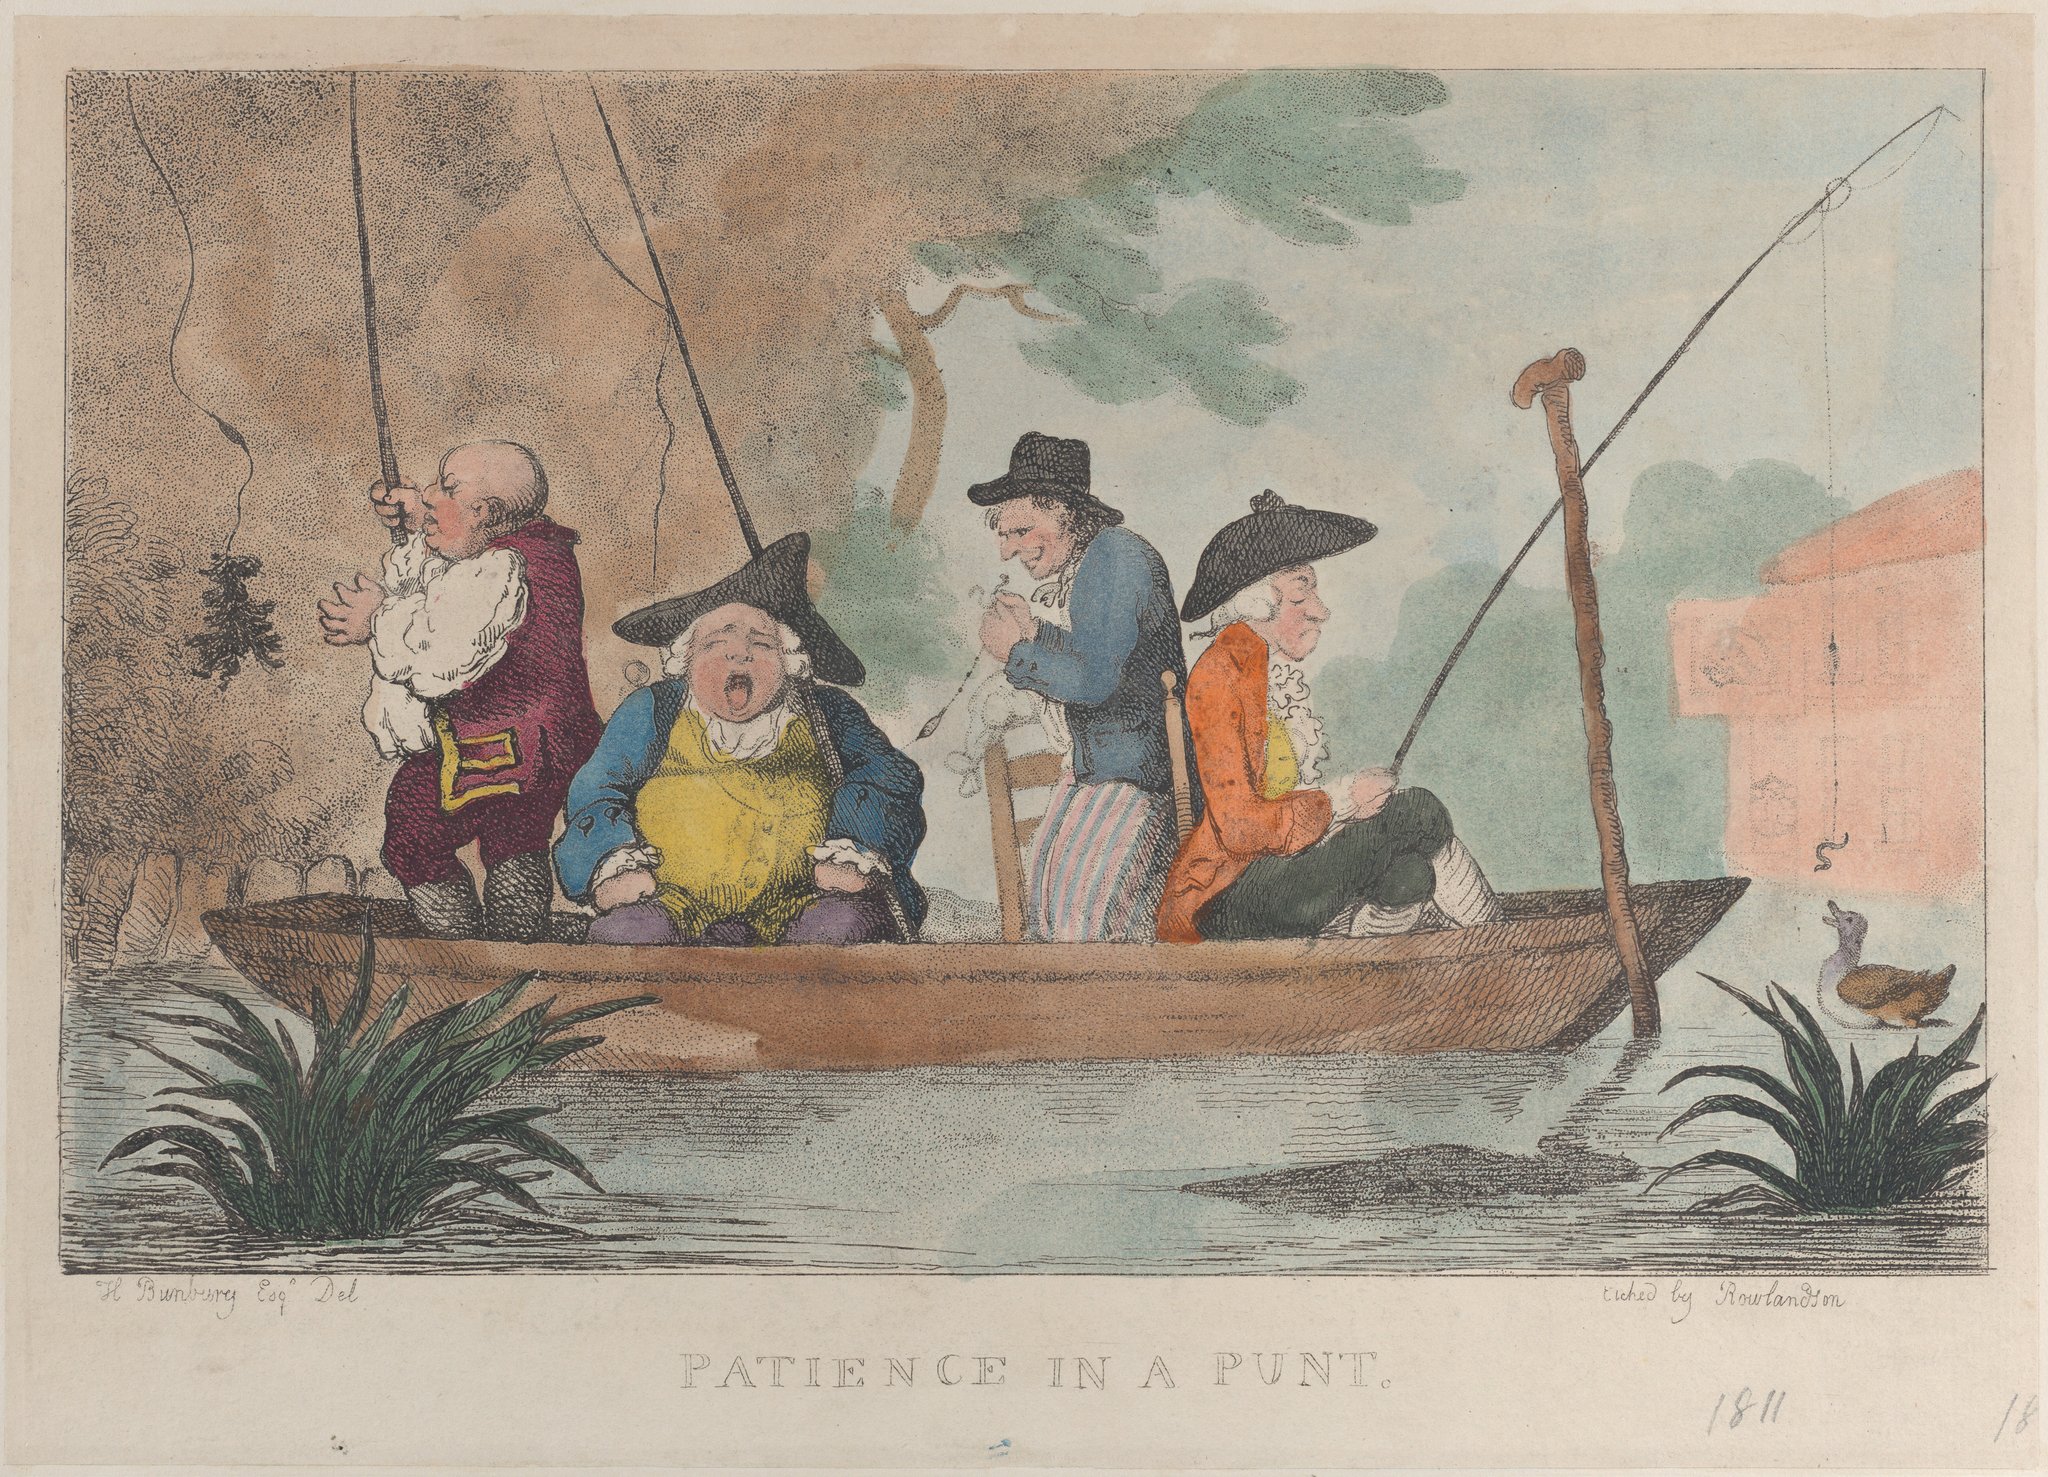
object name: print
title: Patience in a Punt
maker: thomas rowlandson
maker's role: artist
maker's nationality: british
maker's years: 1757-1827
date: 1811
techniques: etching, stippling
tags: satire,men,fishing,boats